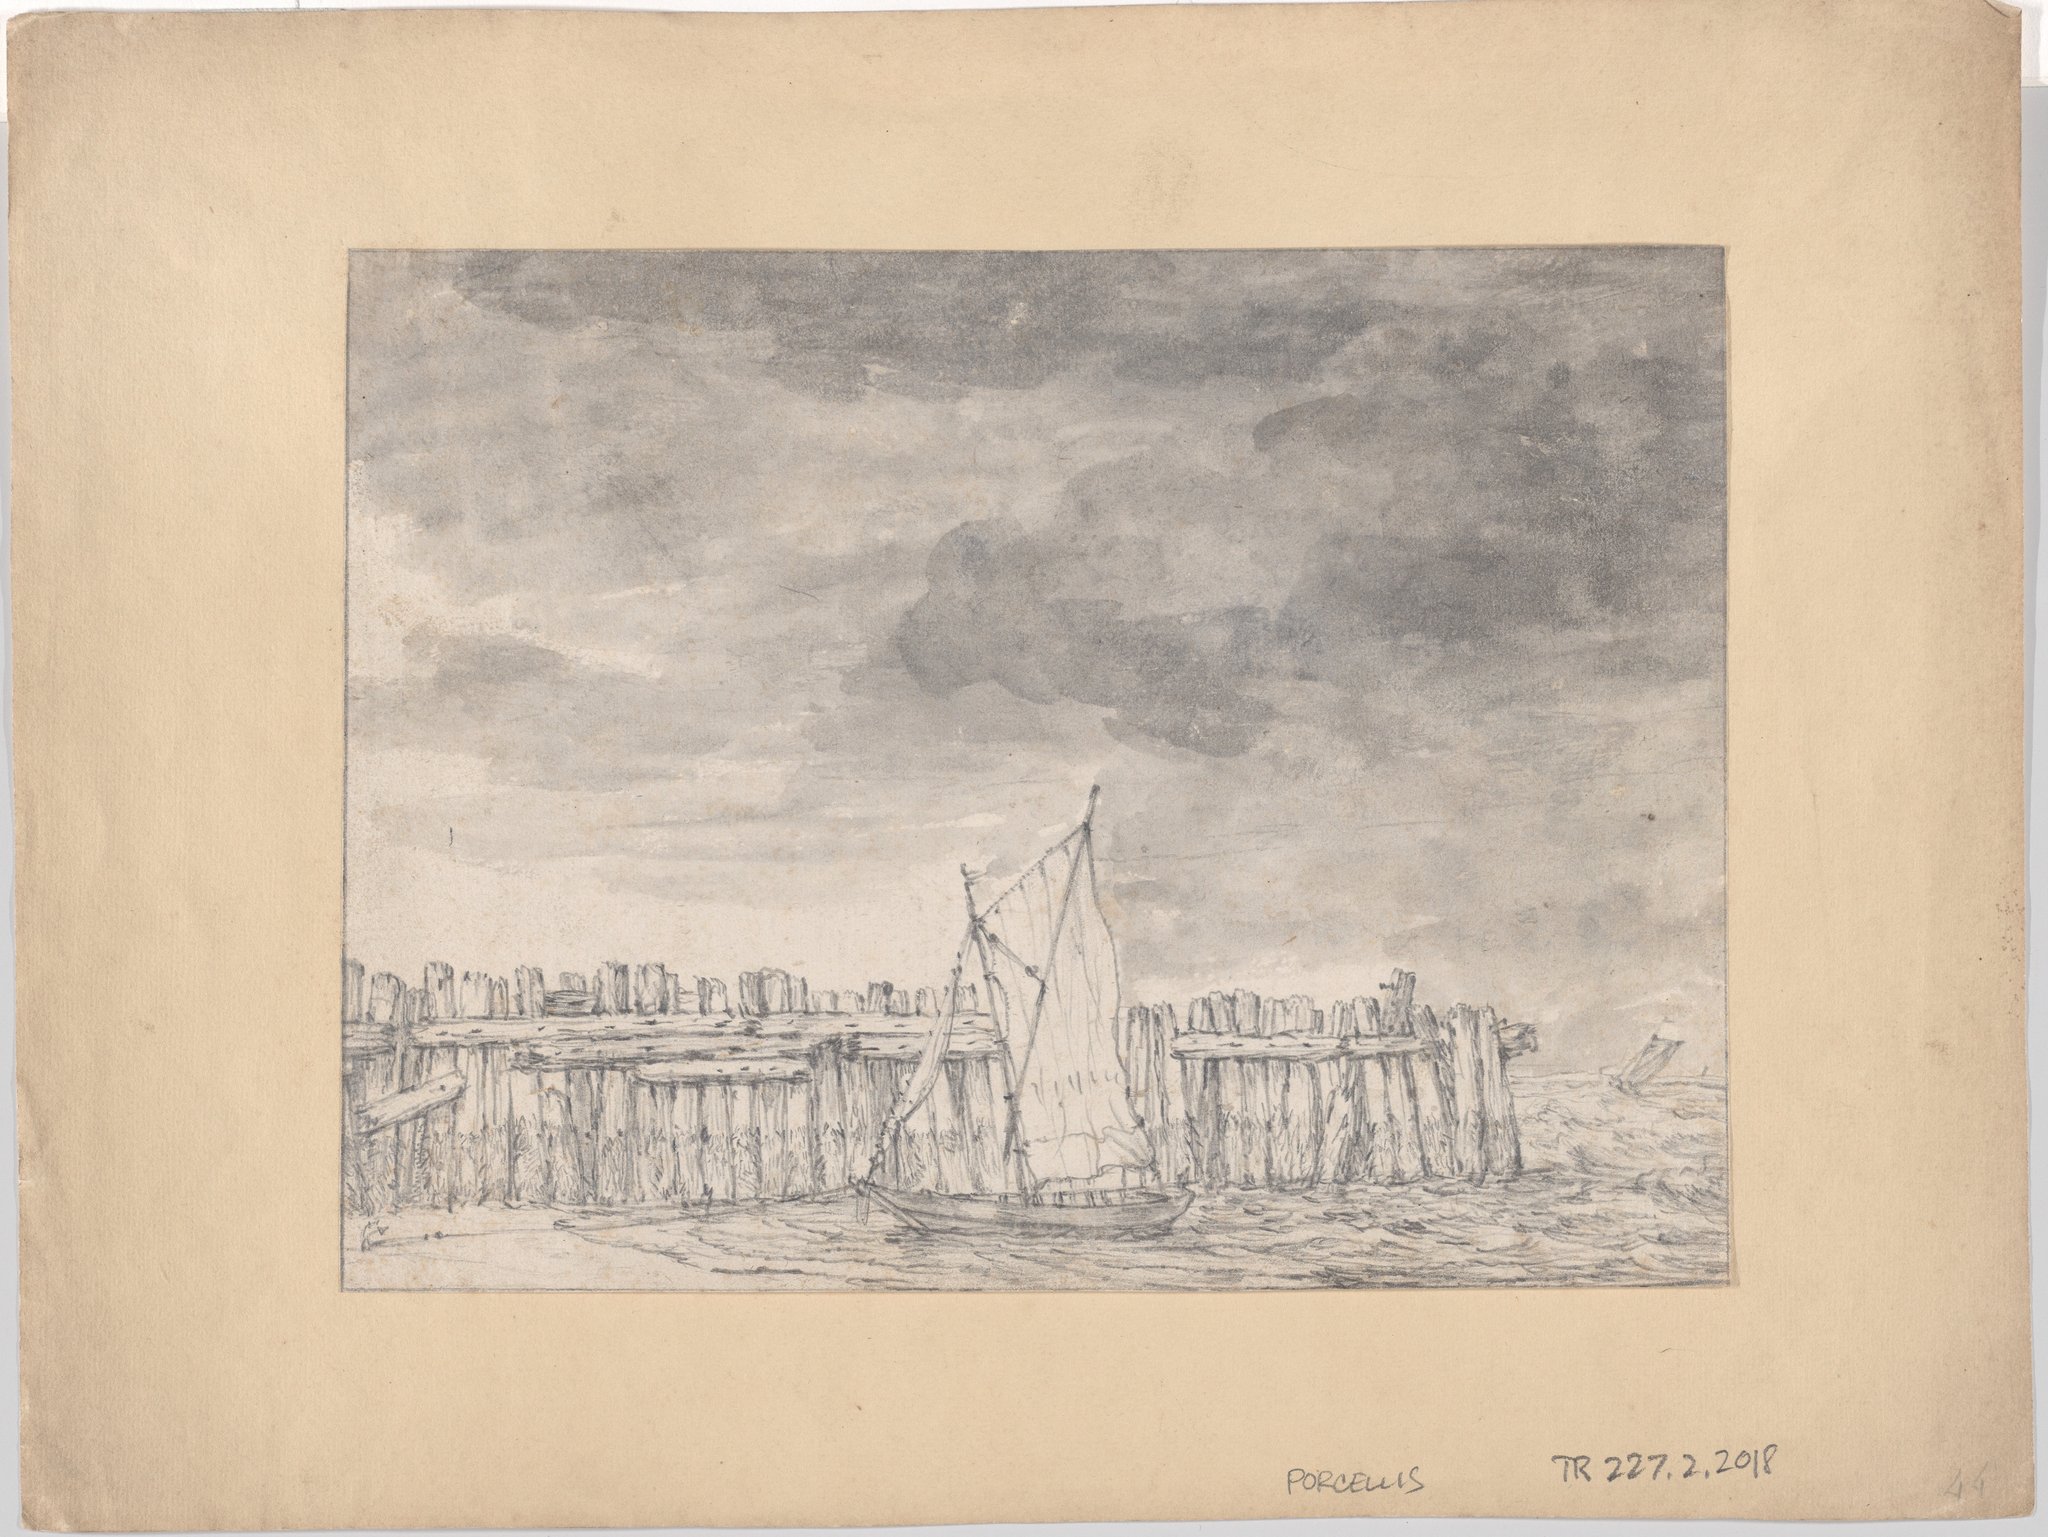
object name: drawing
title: Boat Moored on a Beach by a Wooden Palisade (recto); Study of Trees (verso)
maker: jan porcellis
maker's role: artist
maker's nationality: dutch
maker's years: 1584-1632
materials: chalk, ink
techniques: pen, wash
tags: boats